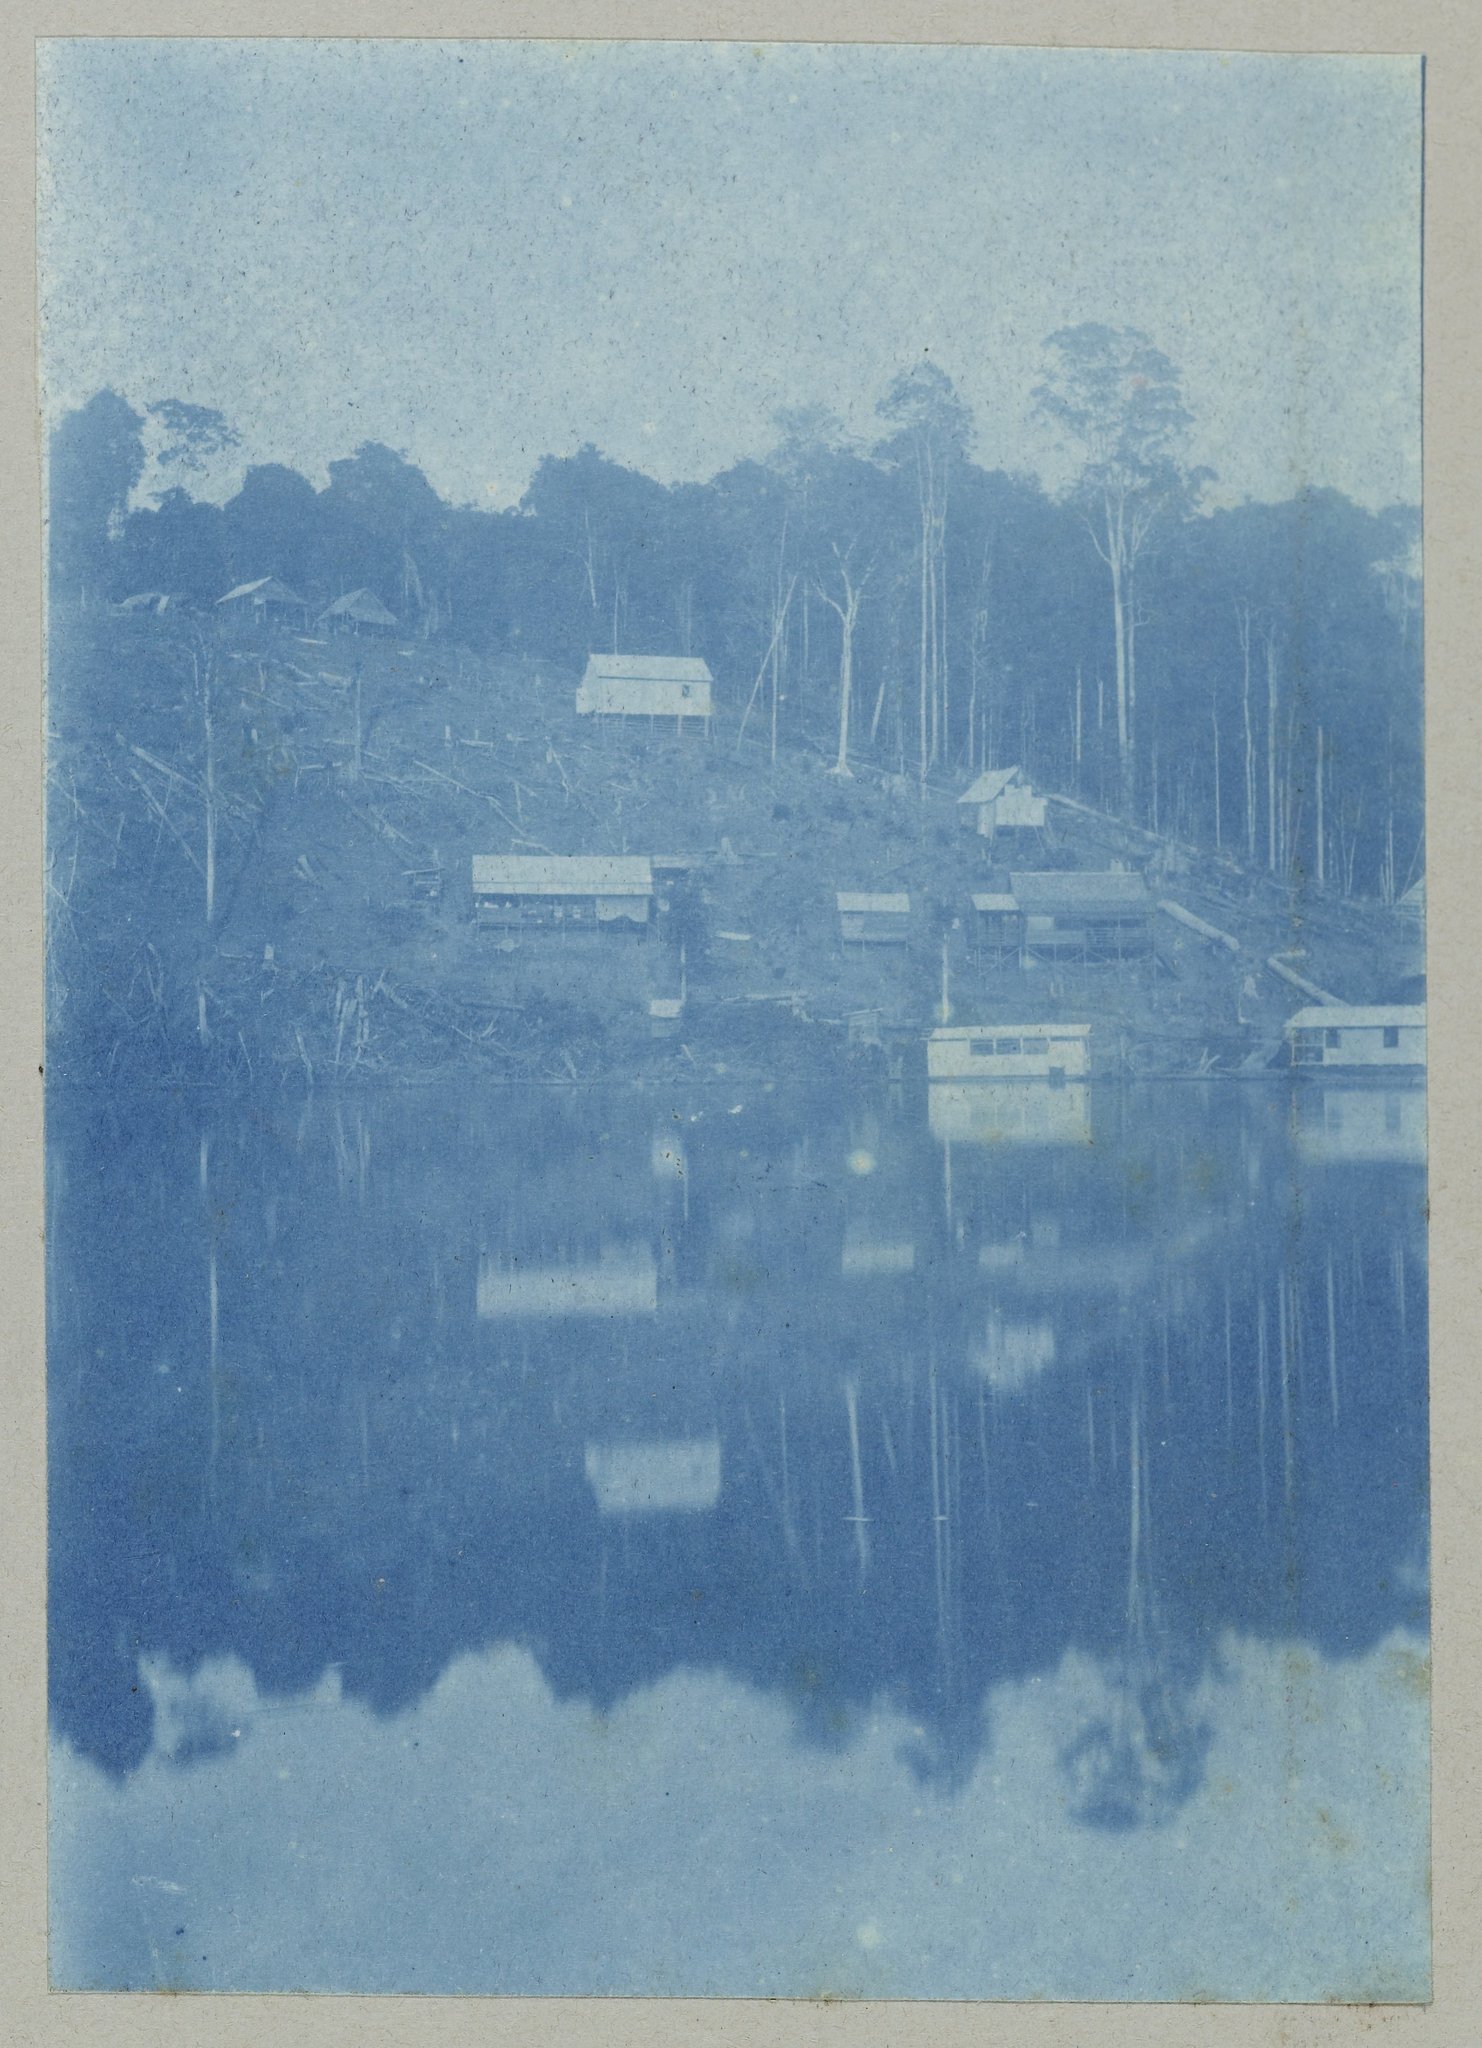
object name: photograph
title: Mäabo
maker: hendrik doijer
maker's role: engineer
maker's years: 1863-1925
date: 1903-1910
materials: photographic support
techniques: cyanotype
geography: suriname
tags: suriname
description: Gezicht op huizen bij het water bij de Maabo Heuvel, voor de afspuiting ten behoeve van de aanleg van de Lawaspoorweg (1903-1912). Onderdeel van het fotoalbum Souvenir de Voyage (deel 1), over het leven van de familie Doijer in en rond de plantage Ma Retraite in Suriname in de jaren 1903-1910.